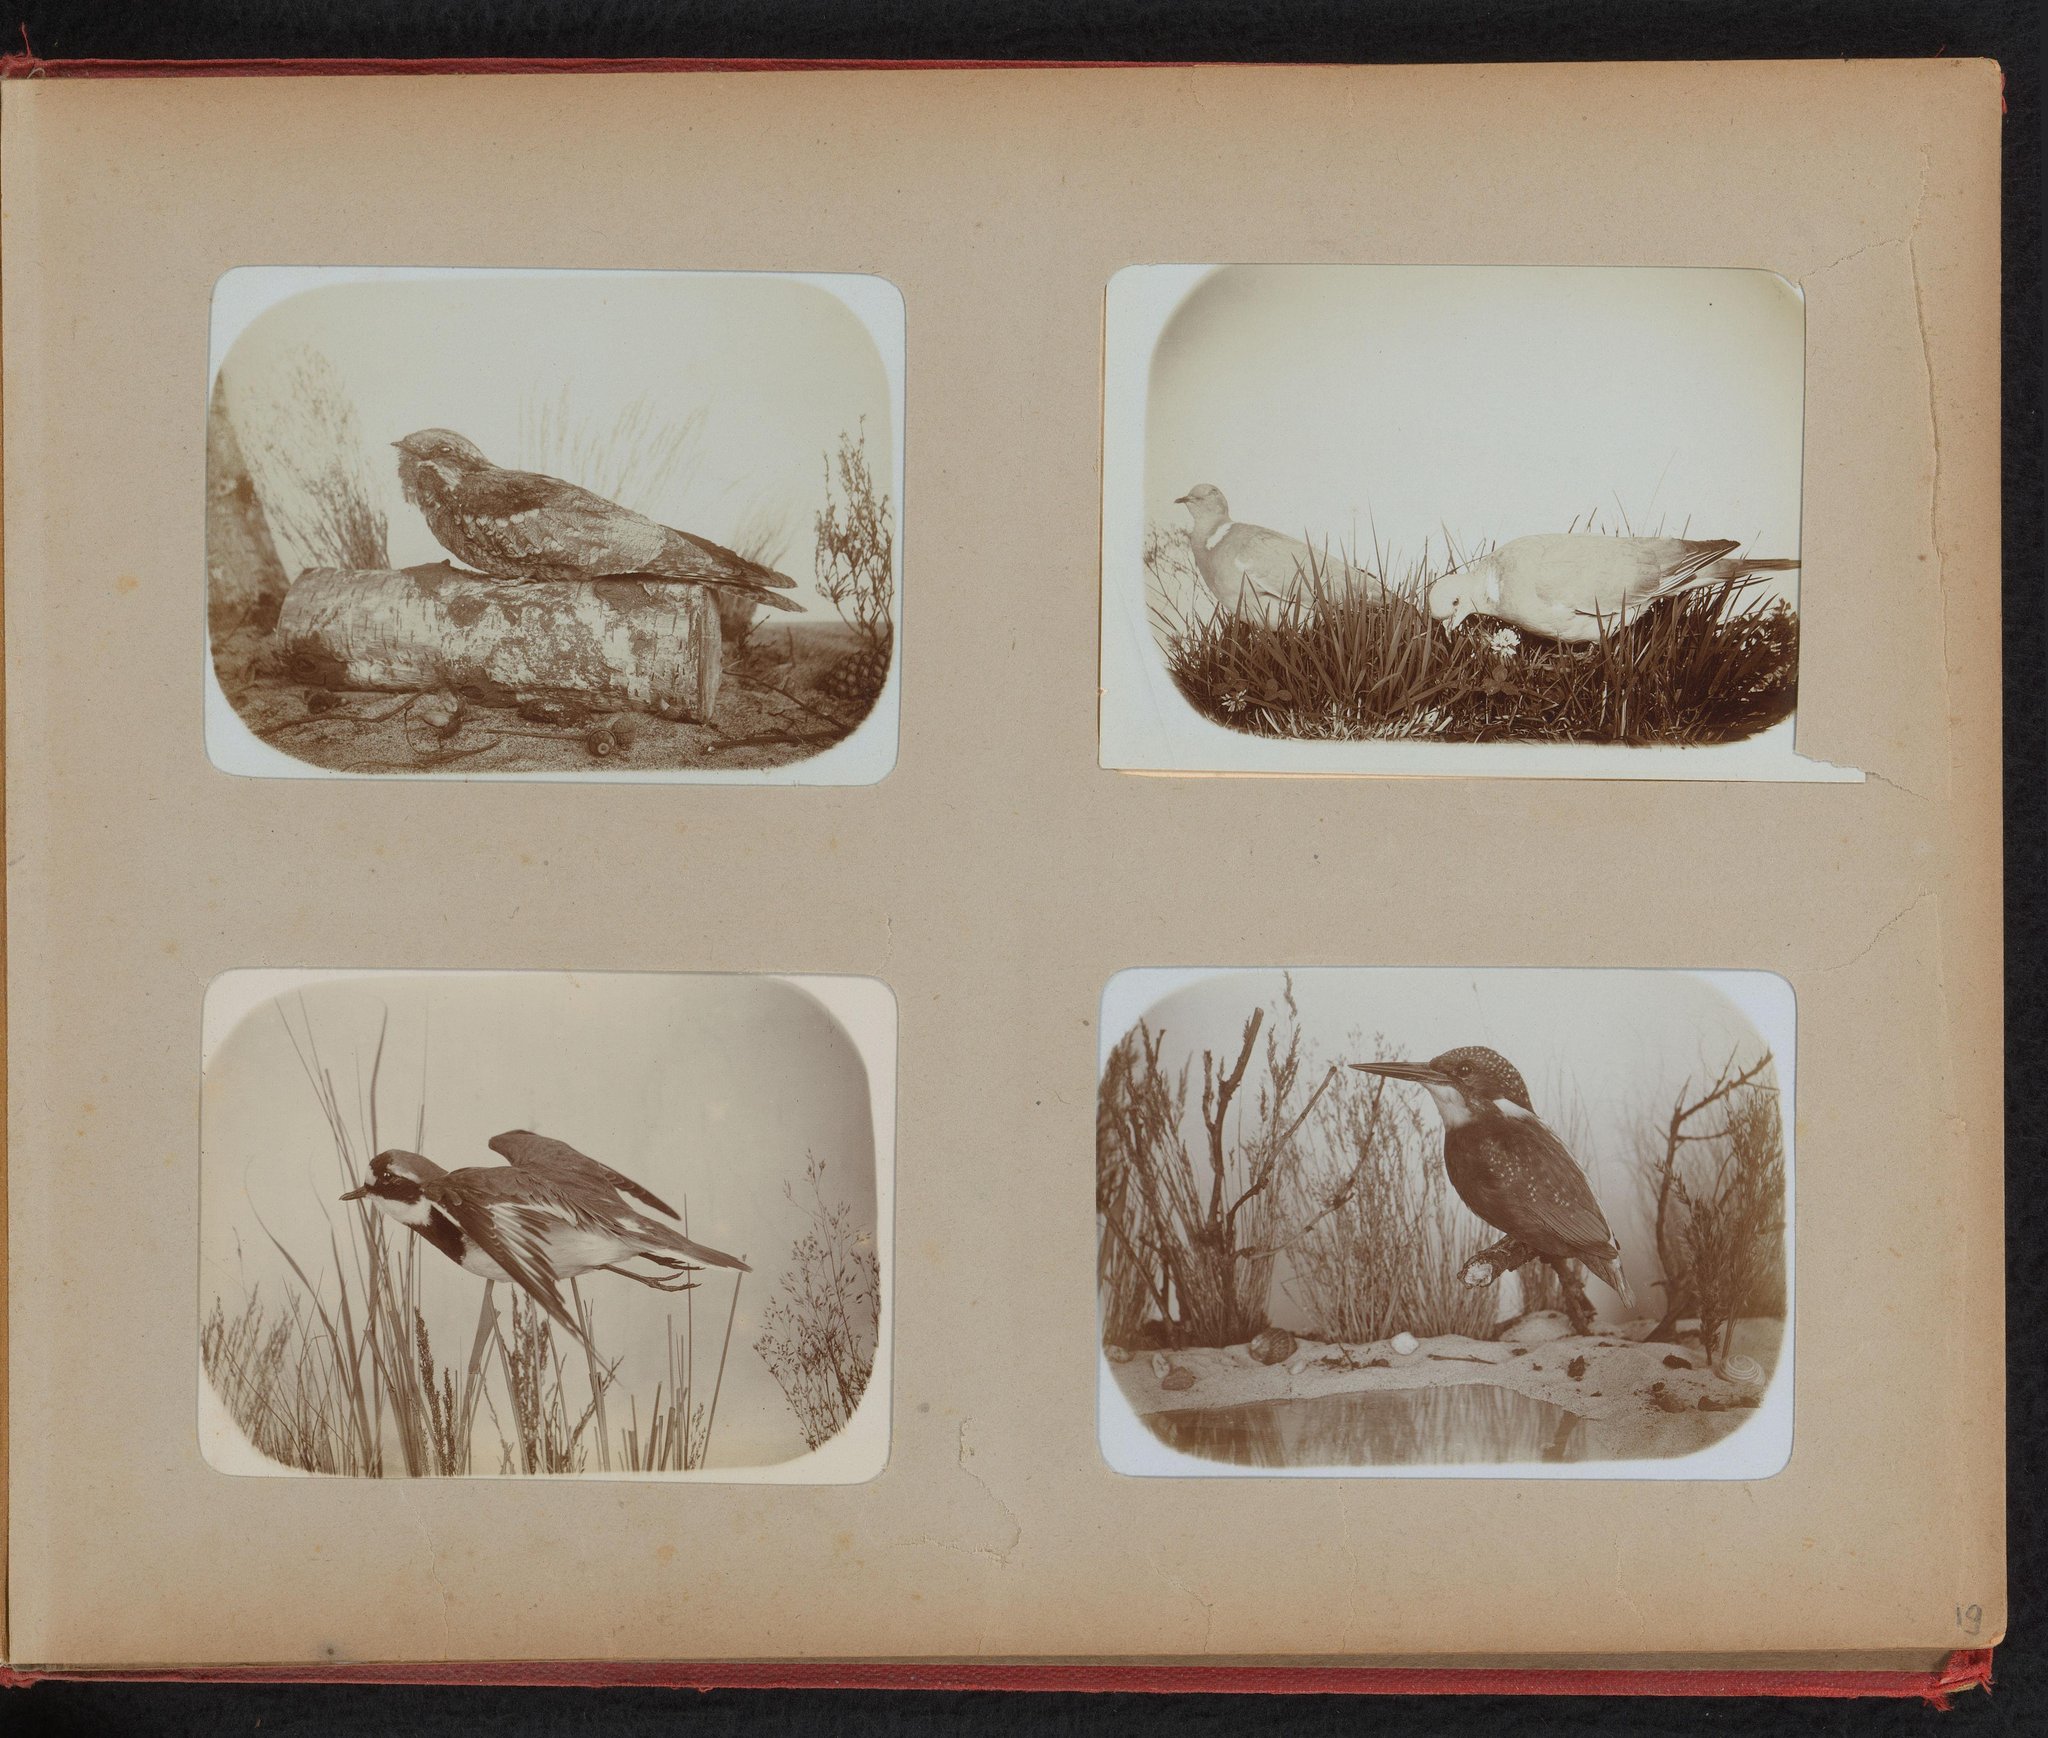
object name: album leaf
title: Opgezette duiven, ijsvogel en twee andere vogels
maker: Anonymous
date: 1895-1910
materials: paper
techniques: gelatin silver print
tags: doves, pigeons, other birds: kingfisher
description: Deze foto's maken deel uit van een album.